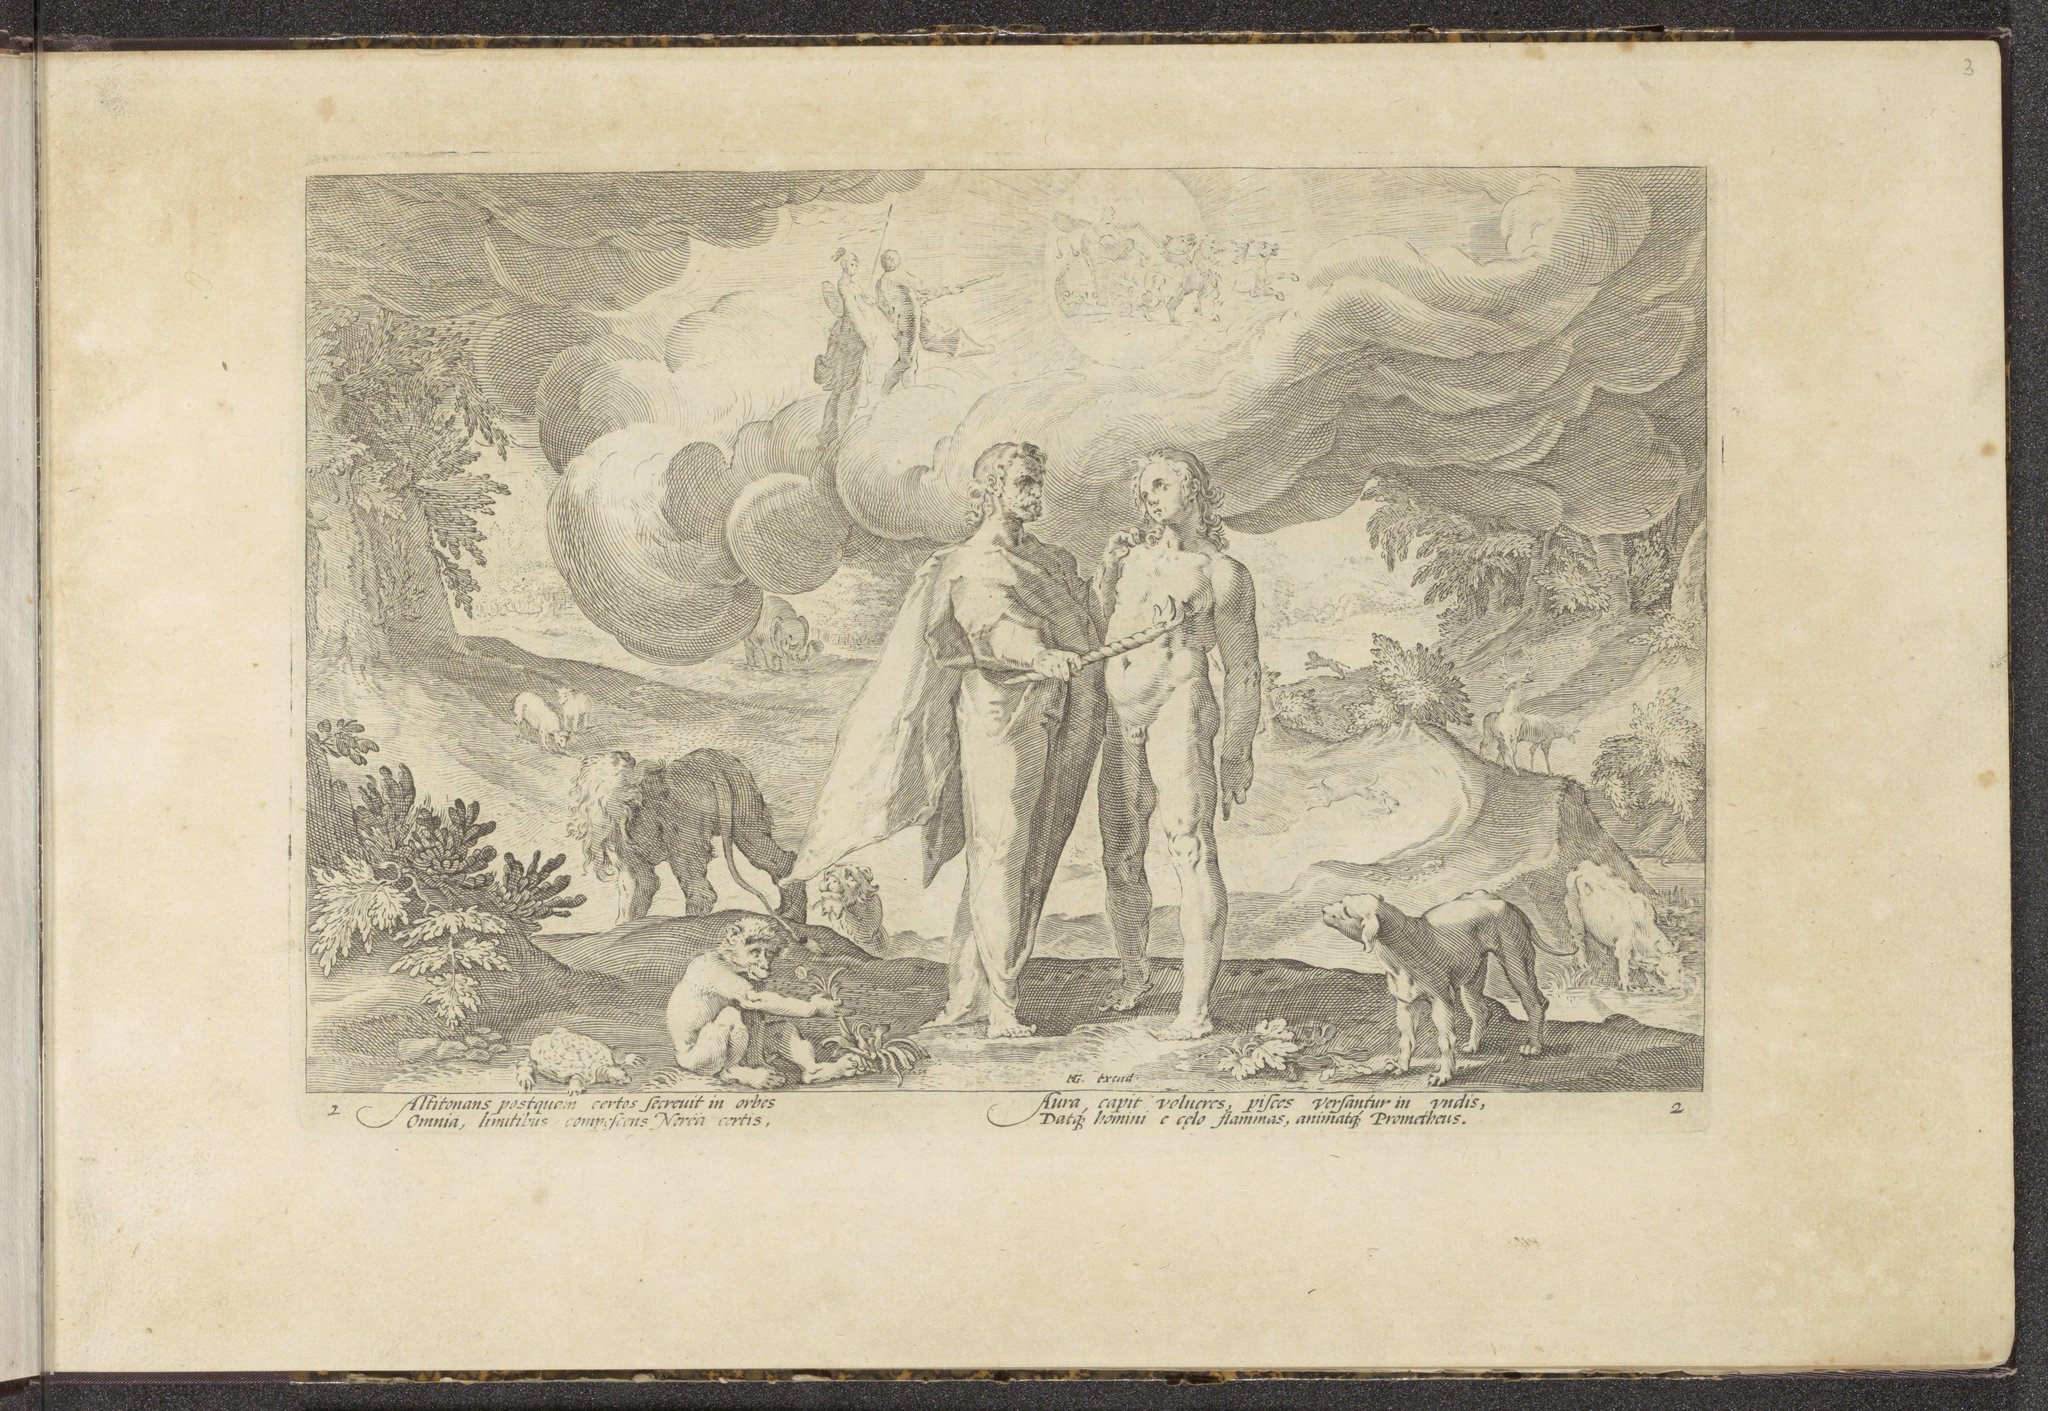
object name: album leaf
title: Prometheus schenkt de mens het vuur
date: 1589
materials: paper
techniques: engraving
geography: haarlem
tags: prometheus brings fire to mankind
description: Prometheus staat naast de menselijke figuur die hij zelf uit slijk geschapen heeft en schenkt hem juist het vuur in de vorm van een toorts. Om de twee mannen verschillende dieren (olifant, leeuw, aap, hond, schildpad, koe, hert). In de wolken Minerva, Jupiter en Helios. Onder de voorstelling twee keer twee versregels in het Latijn. De prent maakt deel uit van een album.